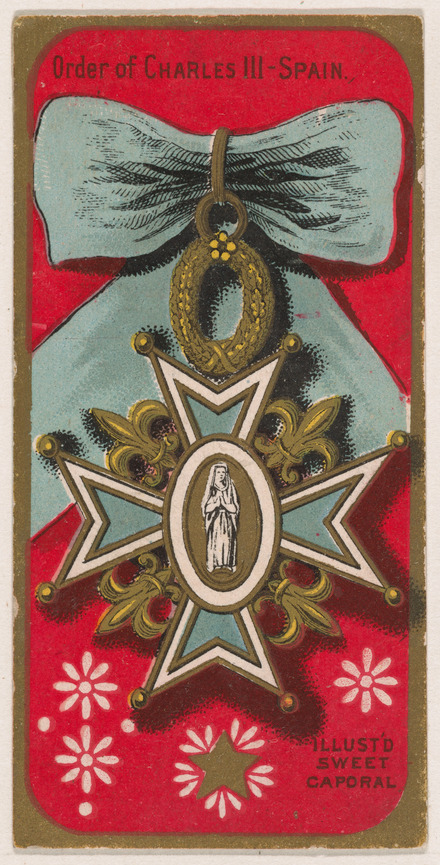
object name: print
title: Order of Charles III, Spain, from the Military Series (N224) issued by Kinney Tobacco Company to promote Sweet Caporal Cigarettes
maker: kinney brothers tobacco company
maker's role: publisher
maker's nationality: american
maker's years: 1869-2011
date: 1888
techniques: color lithograph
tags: women